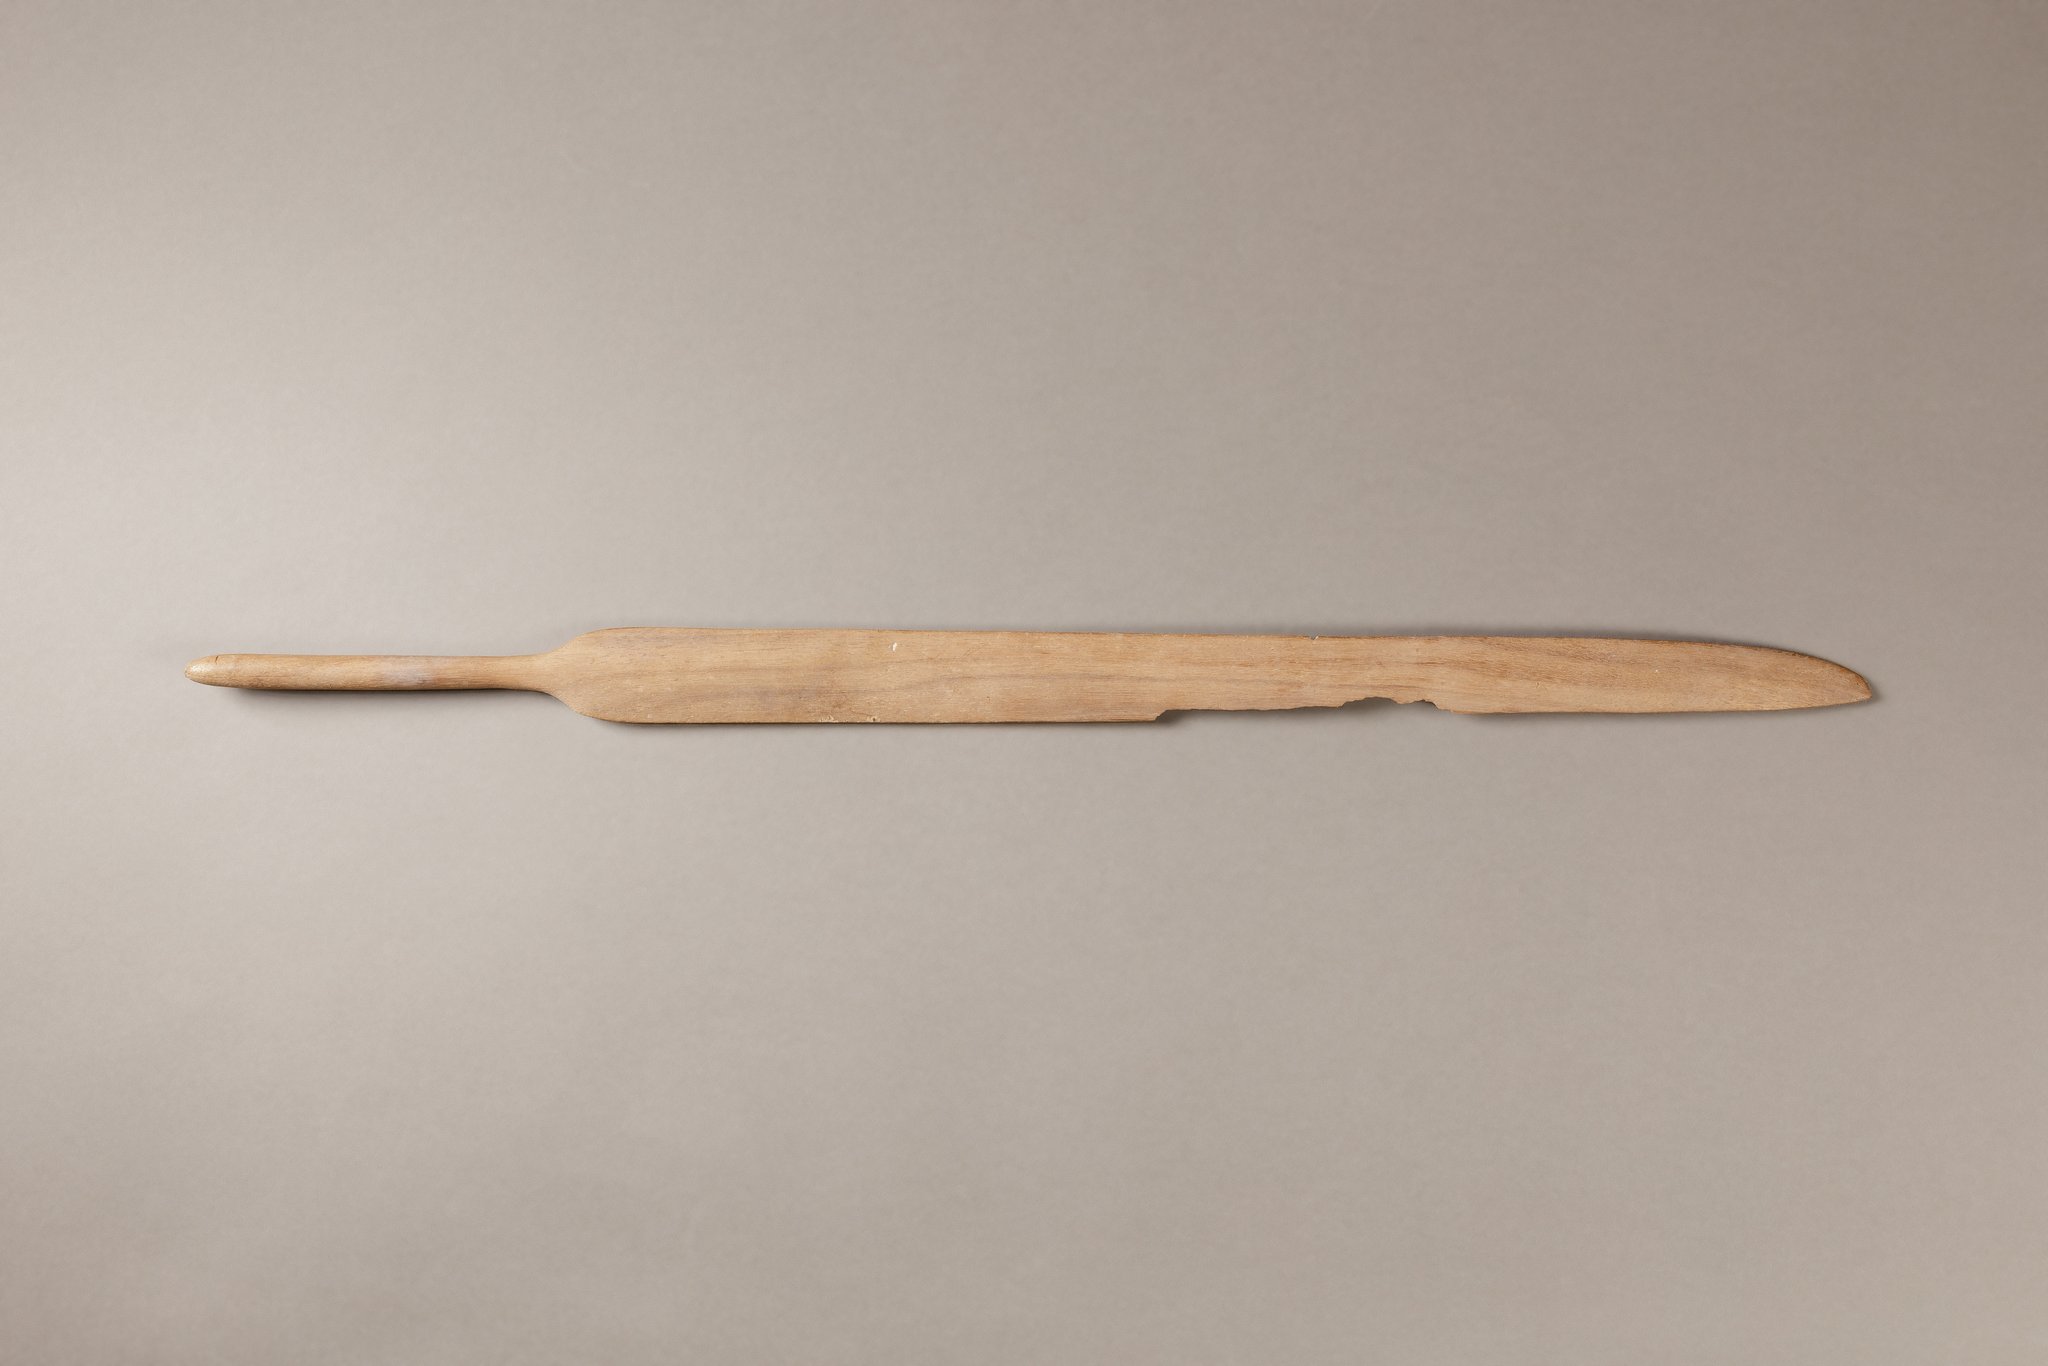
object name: weaving shuttle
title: Weaver's Shuttle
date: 1295-1070 BCE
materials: wood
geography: egypt